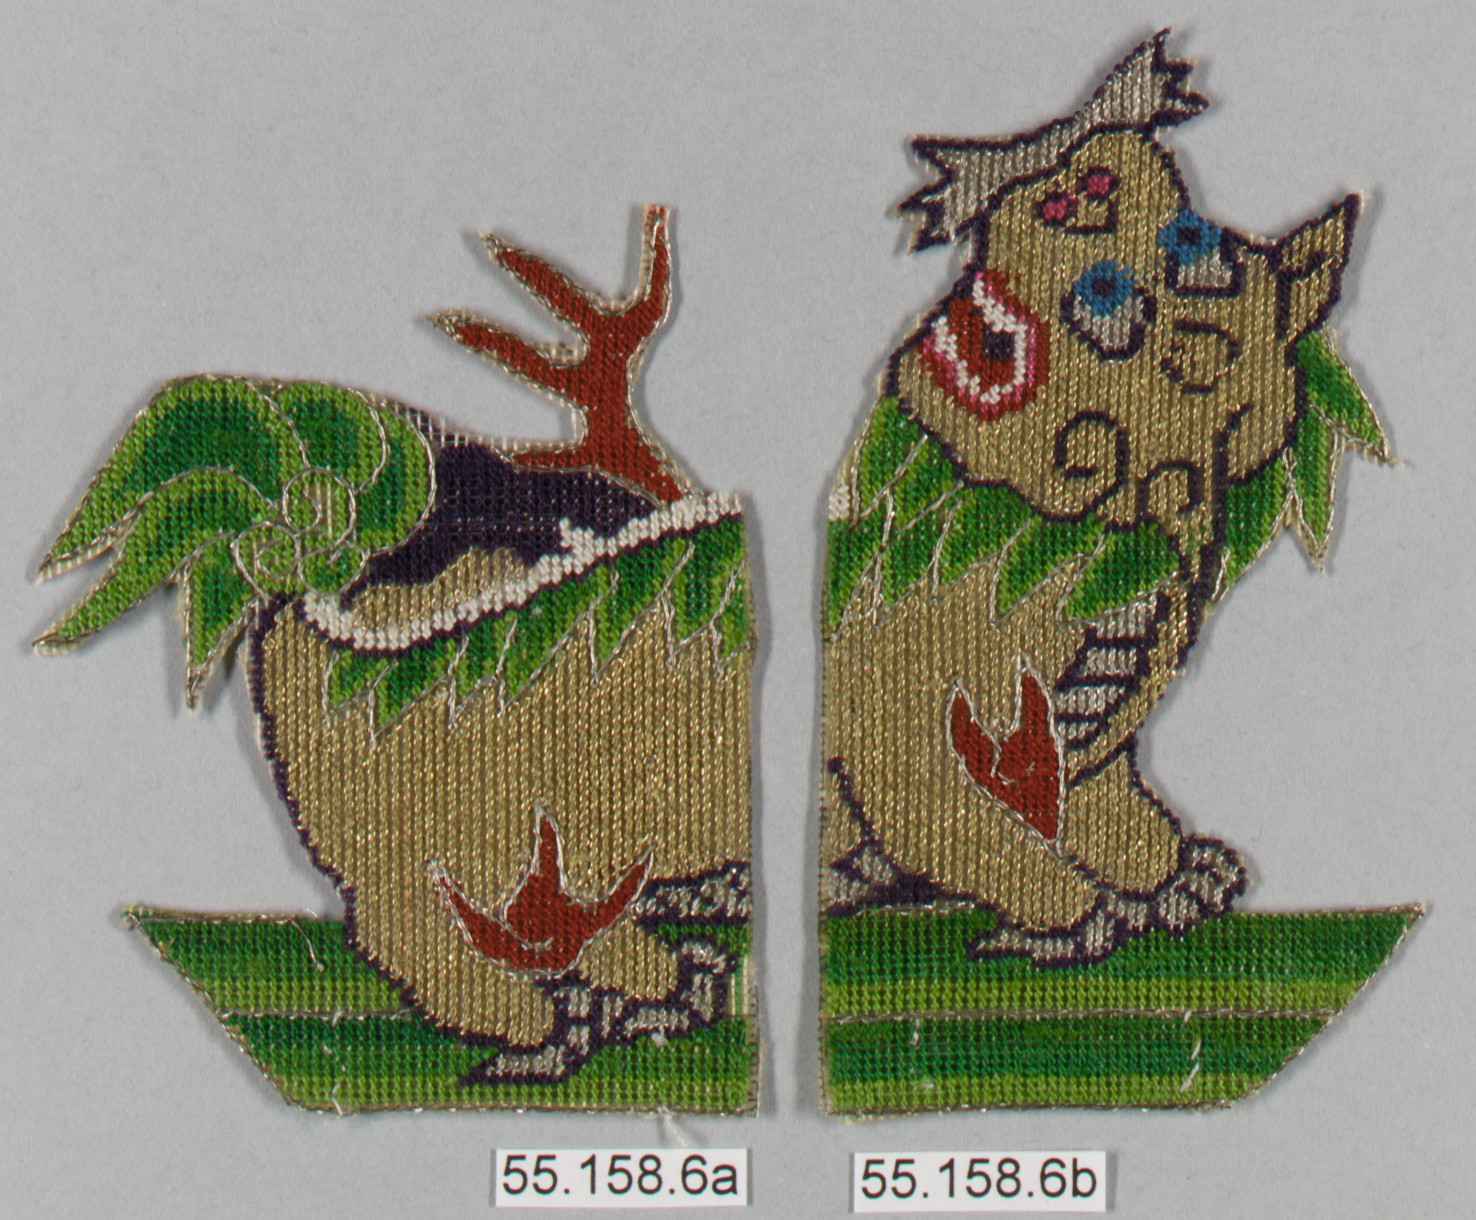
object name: appliqué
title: Applique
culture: chinese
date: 1867-1933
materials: metal thread, silk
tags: animals